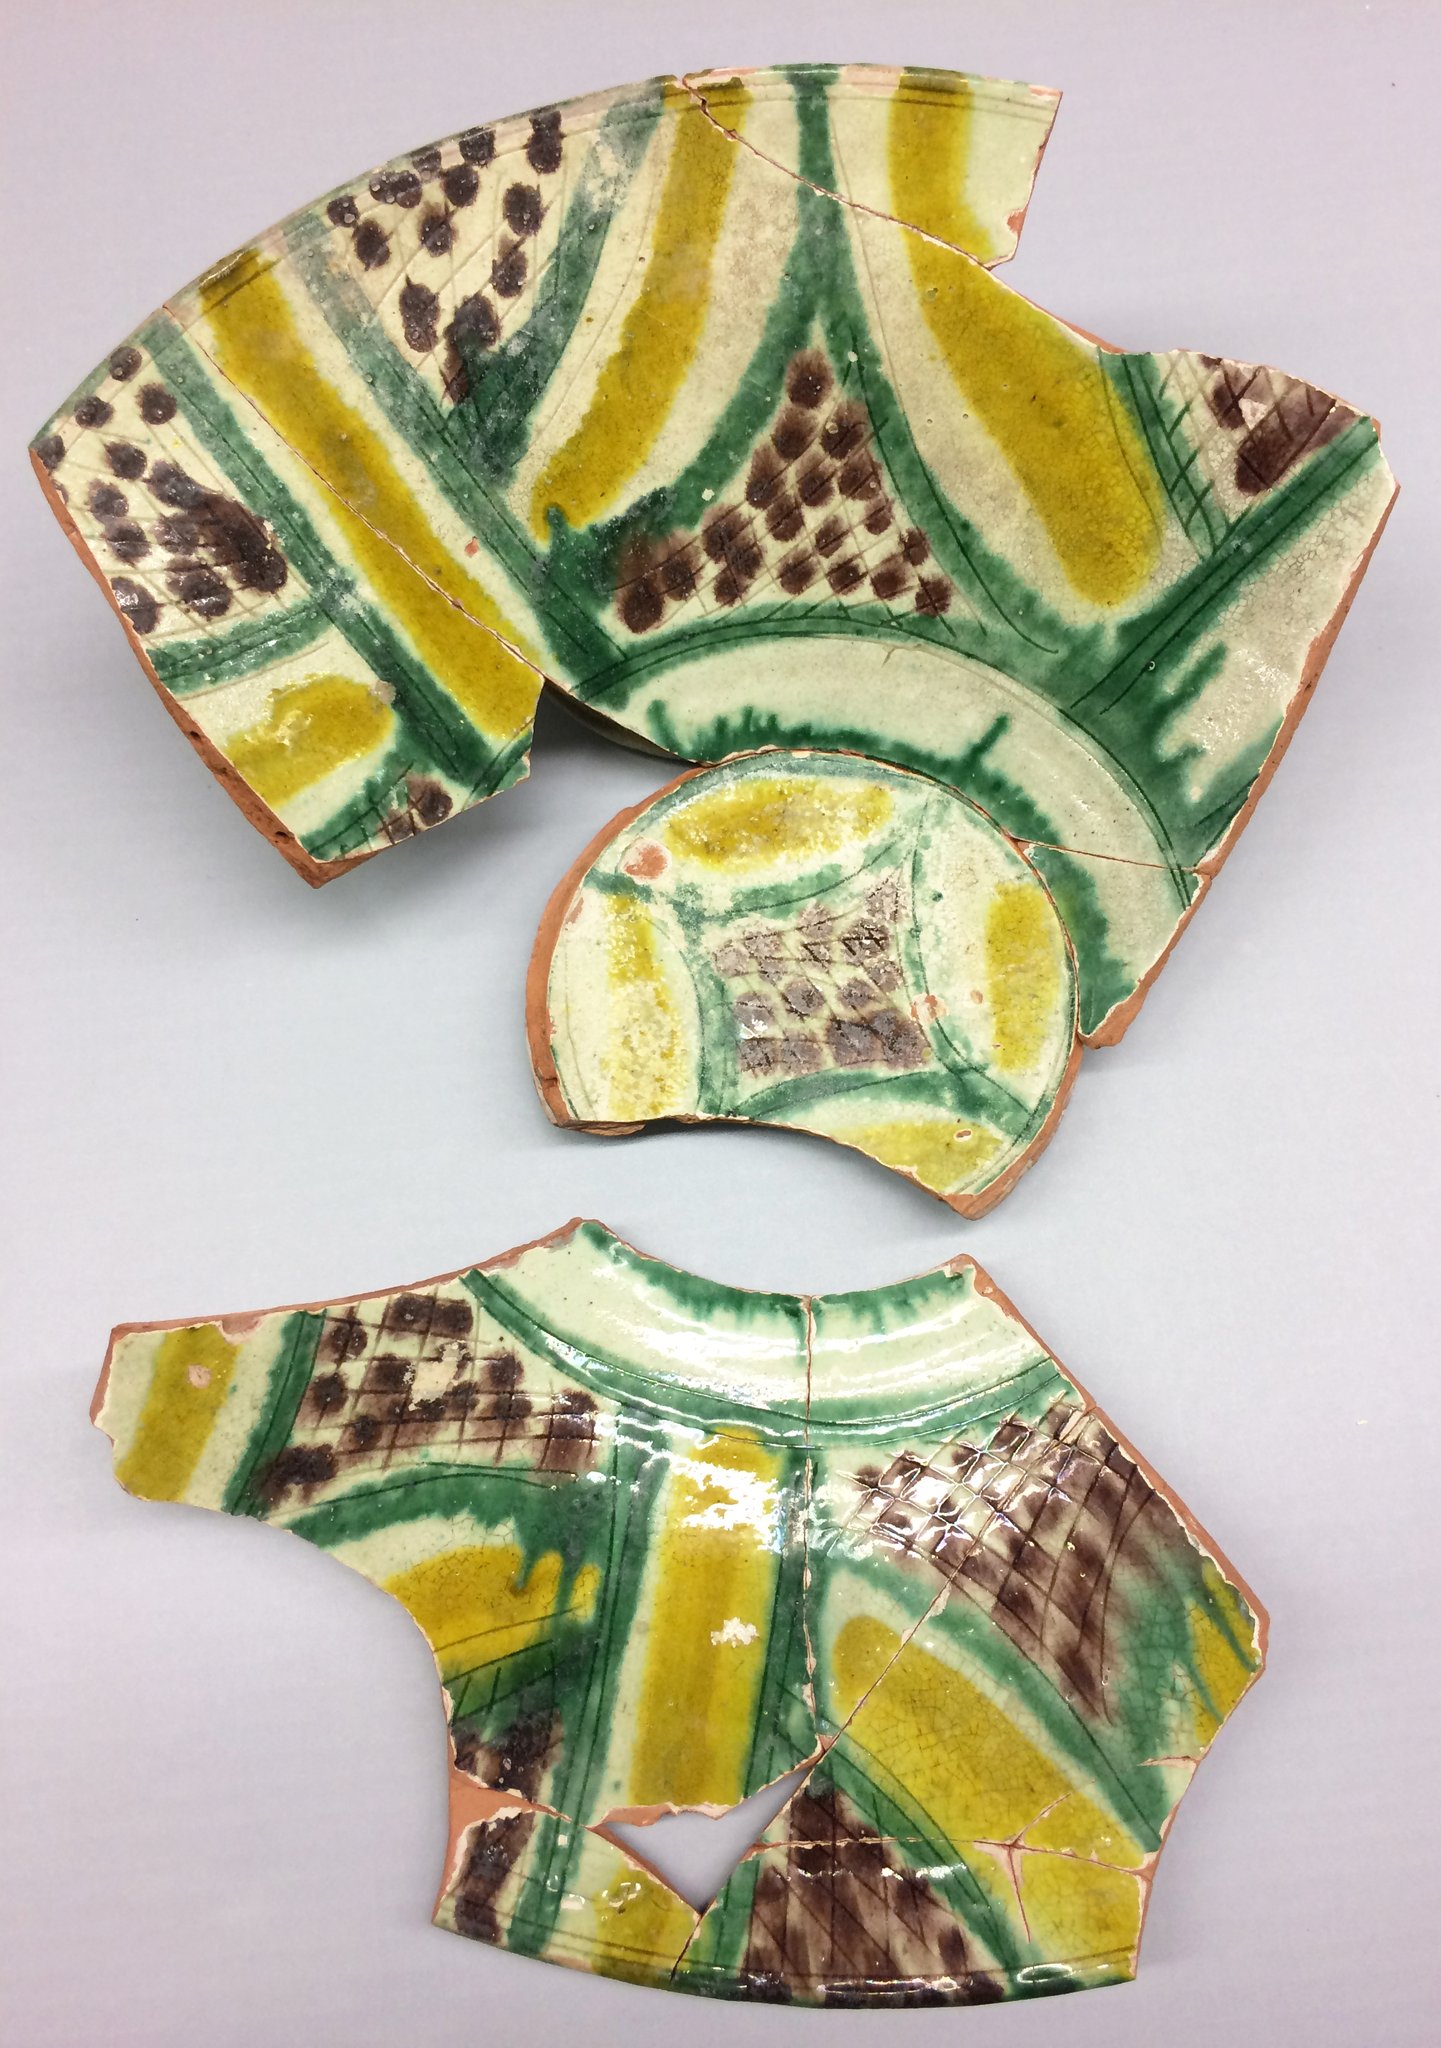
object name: bowl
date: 801-900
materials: earthenware, glaze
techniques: incising, polychrome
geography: iran